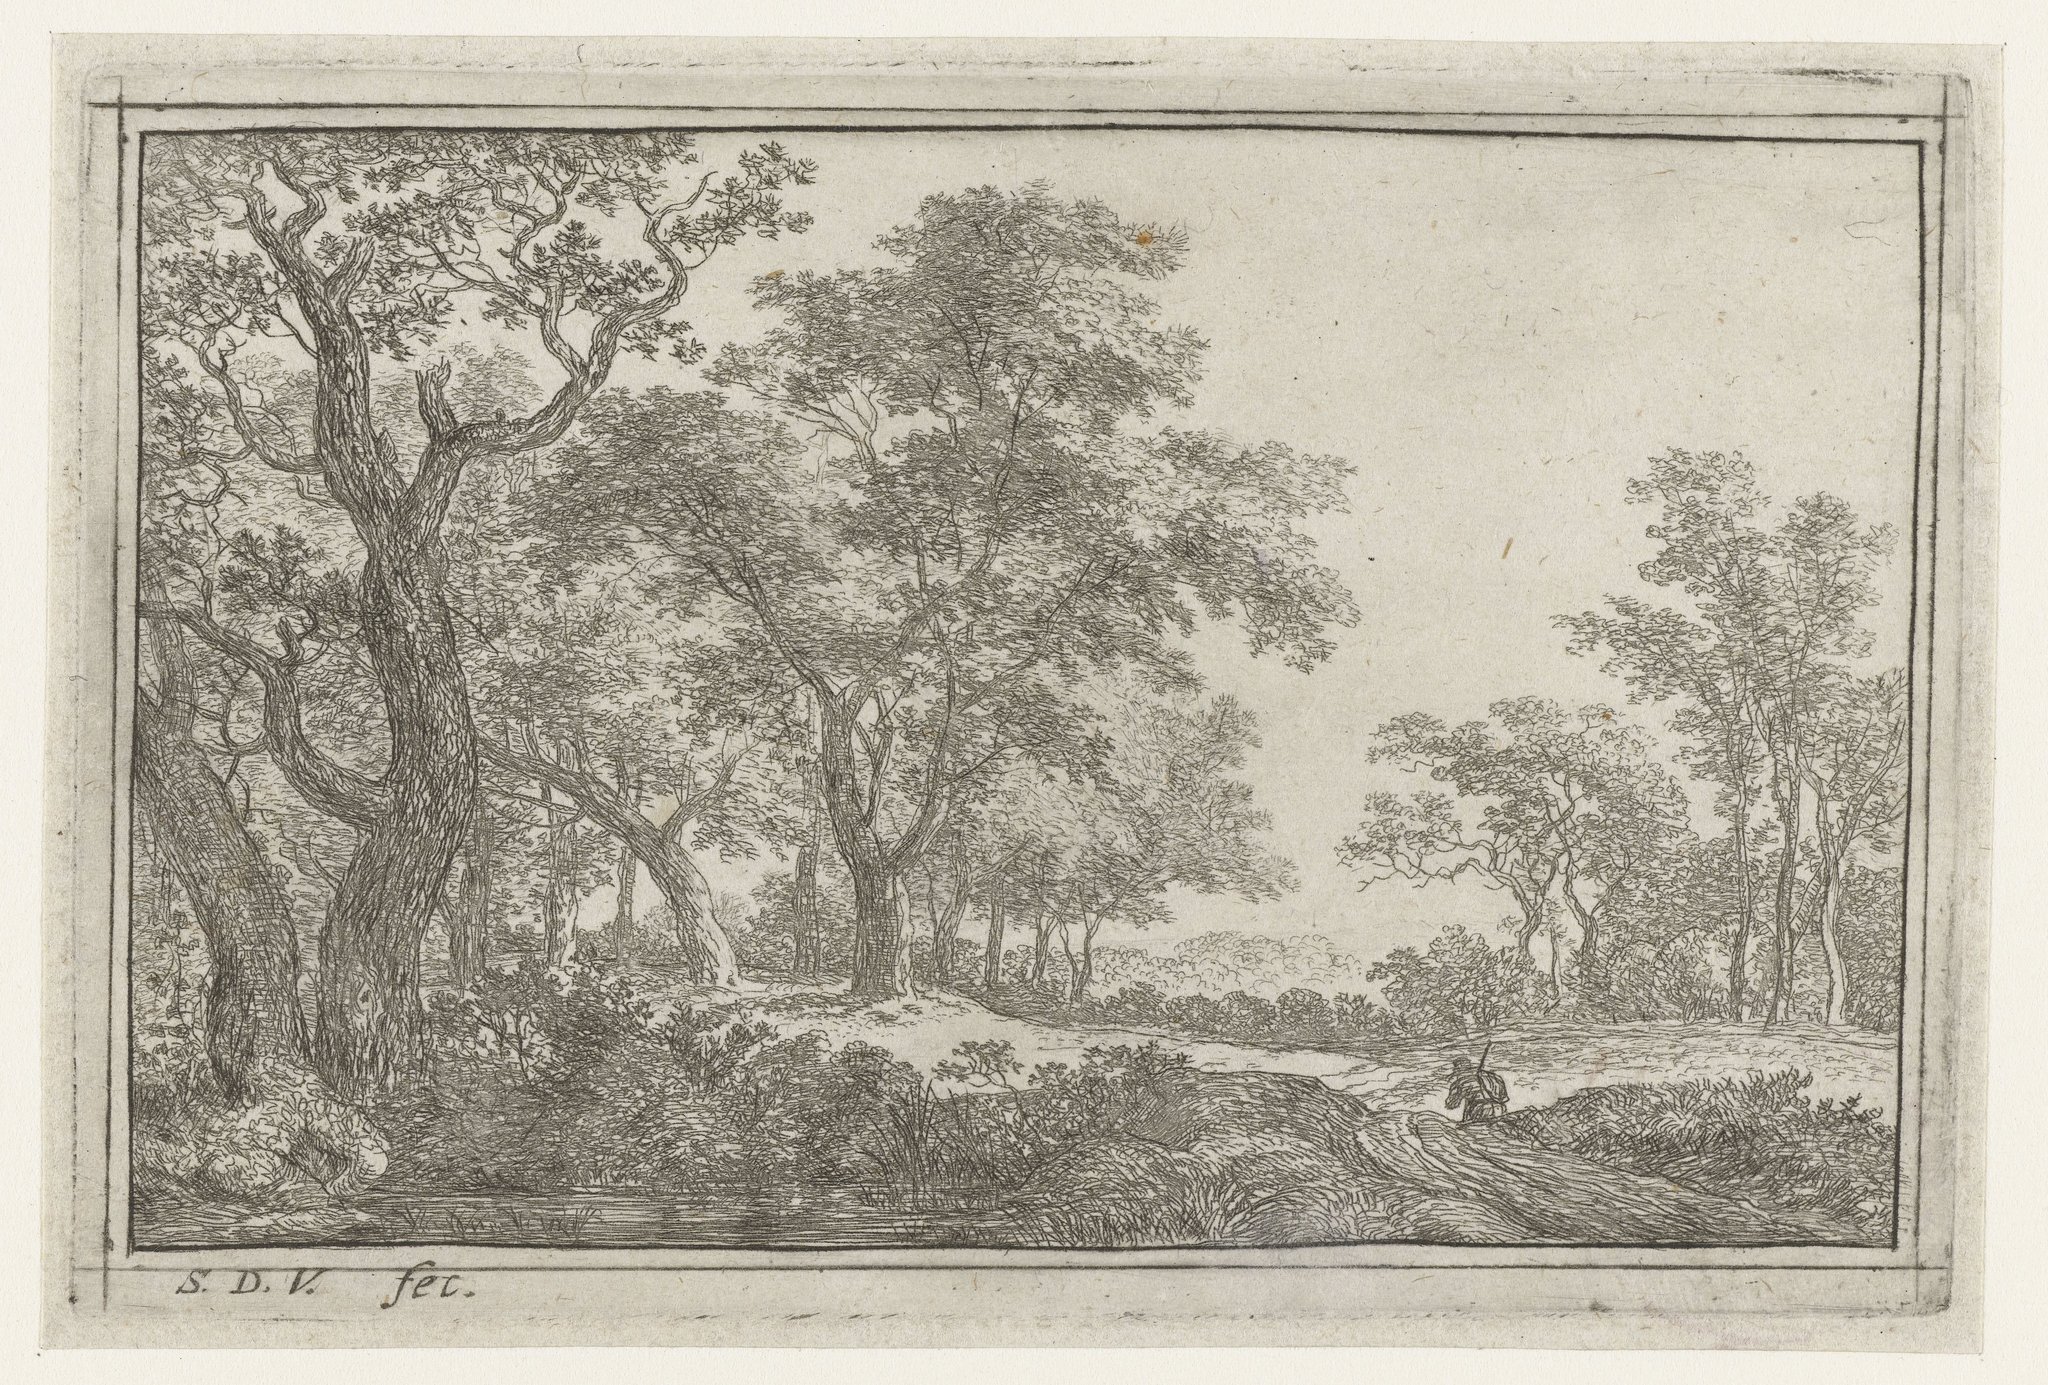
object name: print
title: Pad door het bos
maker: simon de vlieger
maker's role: draughtsman, painter, print maker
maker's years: 1600-1653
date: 1610-1653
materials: paper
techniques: drypoint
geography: low countries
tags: road, path, forest, wood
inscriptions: collector's mark: Lugt 240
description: Wandelaar op een pad door een bosachtig landschap.